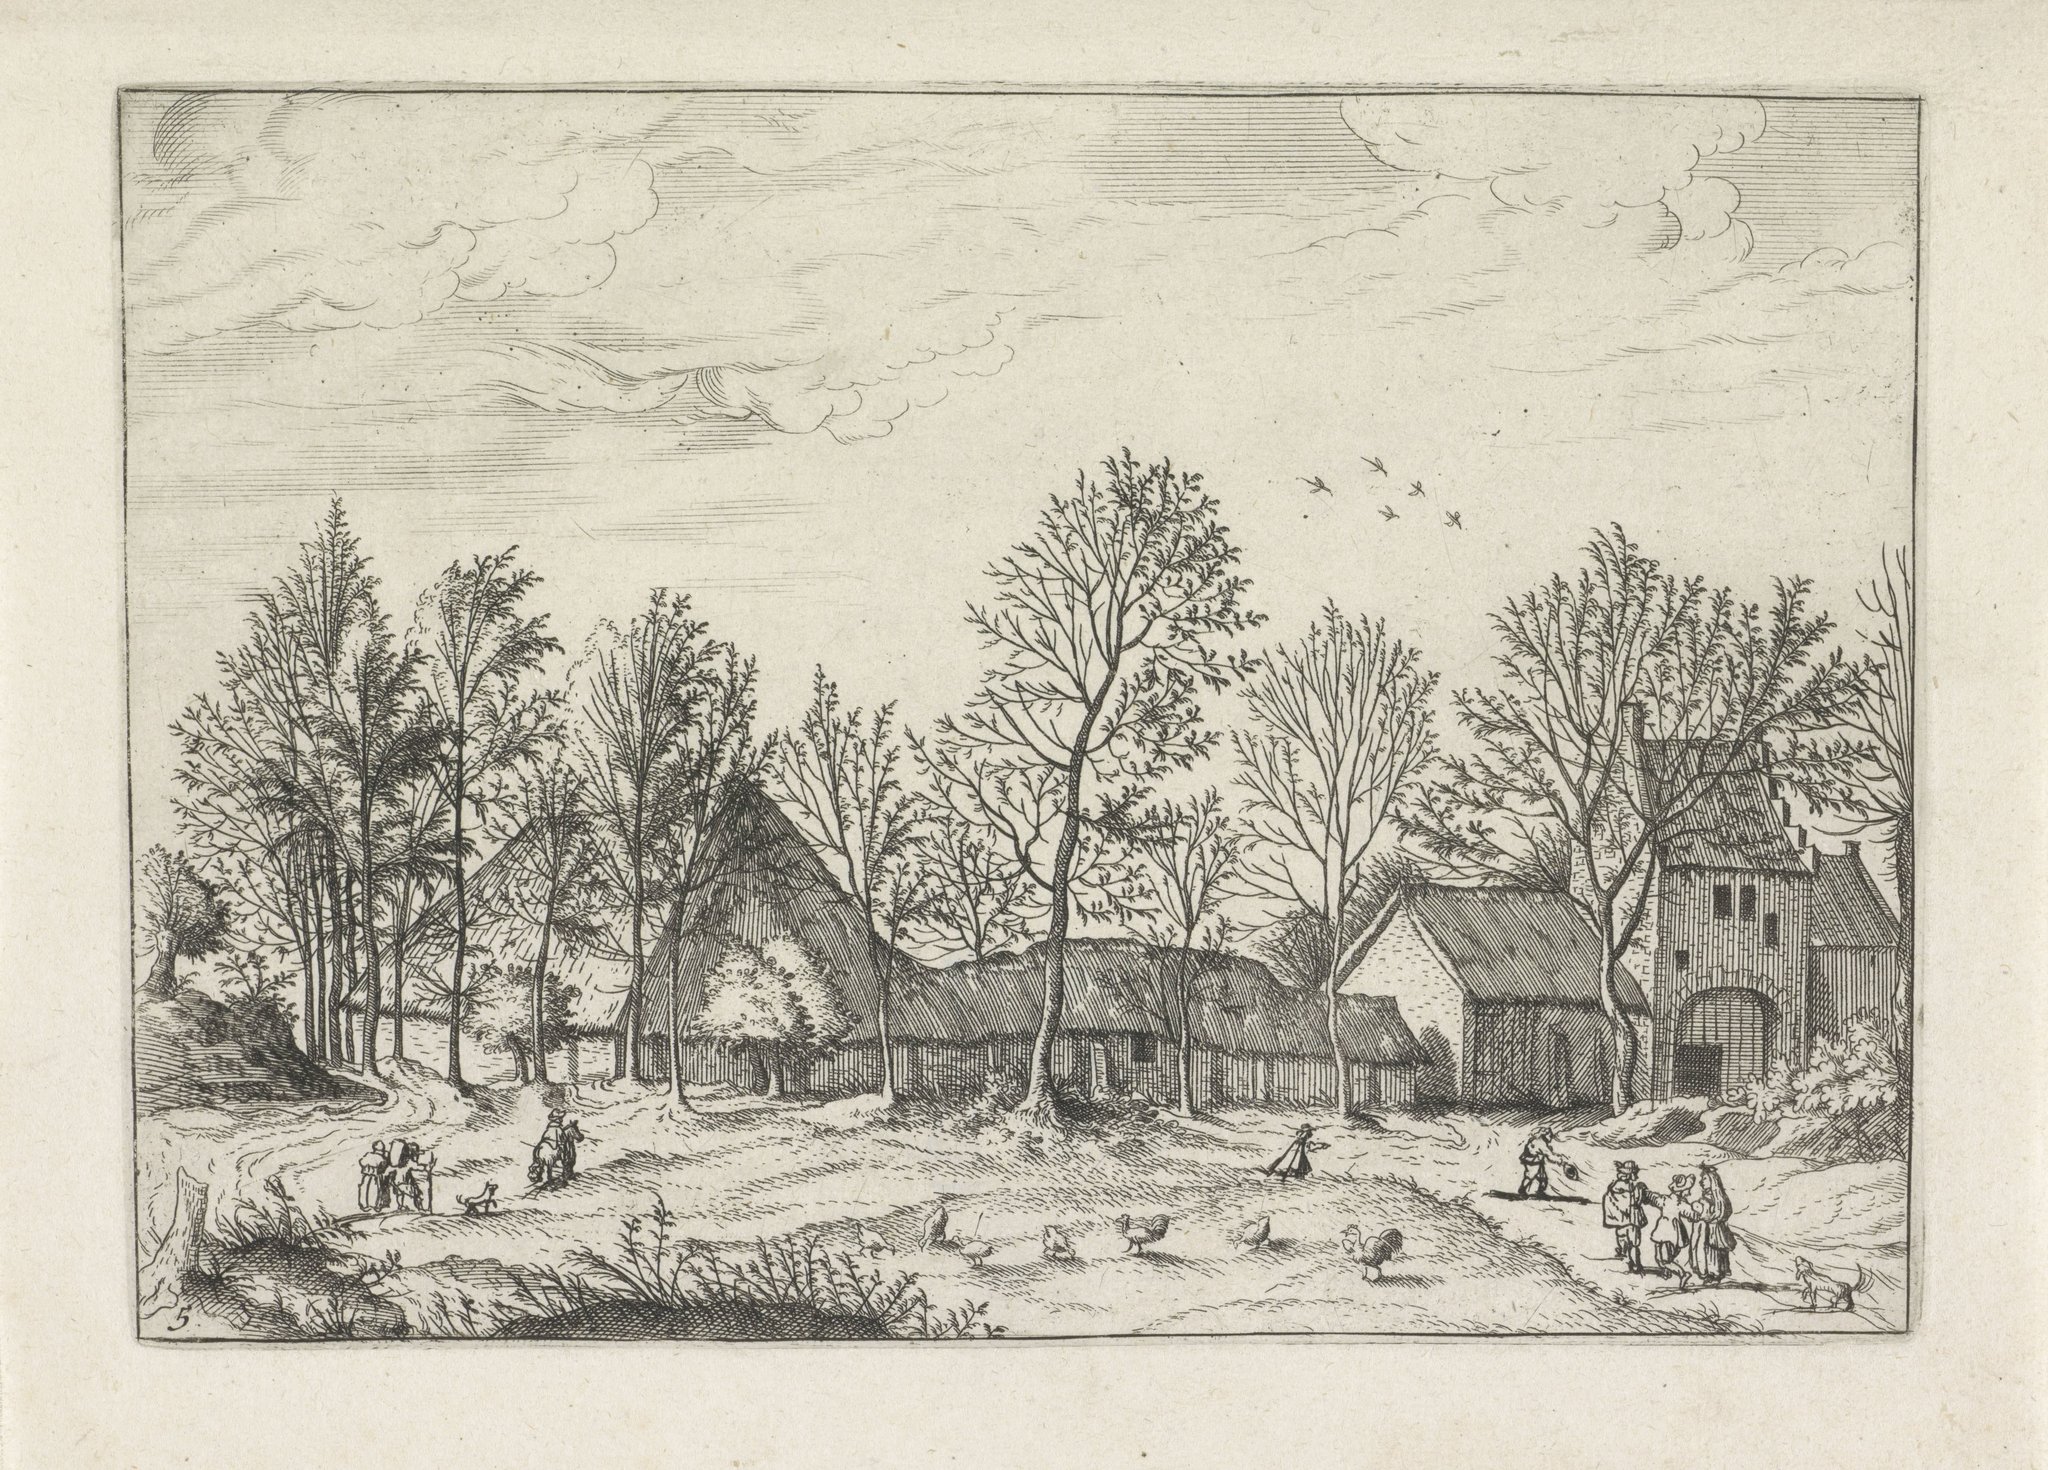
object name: print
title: Boerderij met poortgebouw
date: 1559-1561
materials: paper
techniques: etching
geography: antwerp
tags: gate, entrance, farm (building)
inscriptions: collector's mark: Lugt 2228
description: Links een boerderij omringd door bomen. Rechts een poortgebouw.